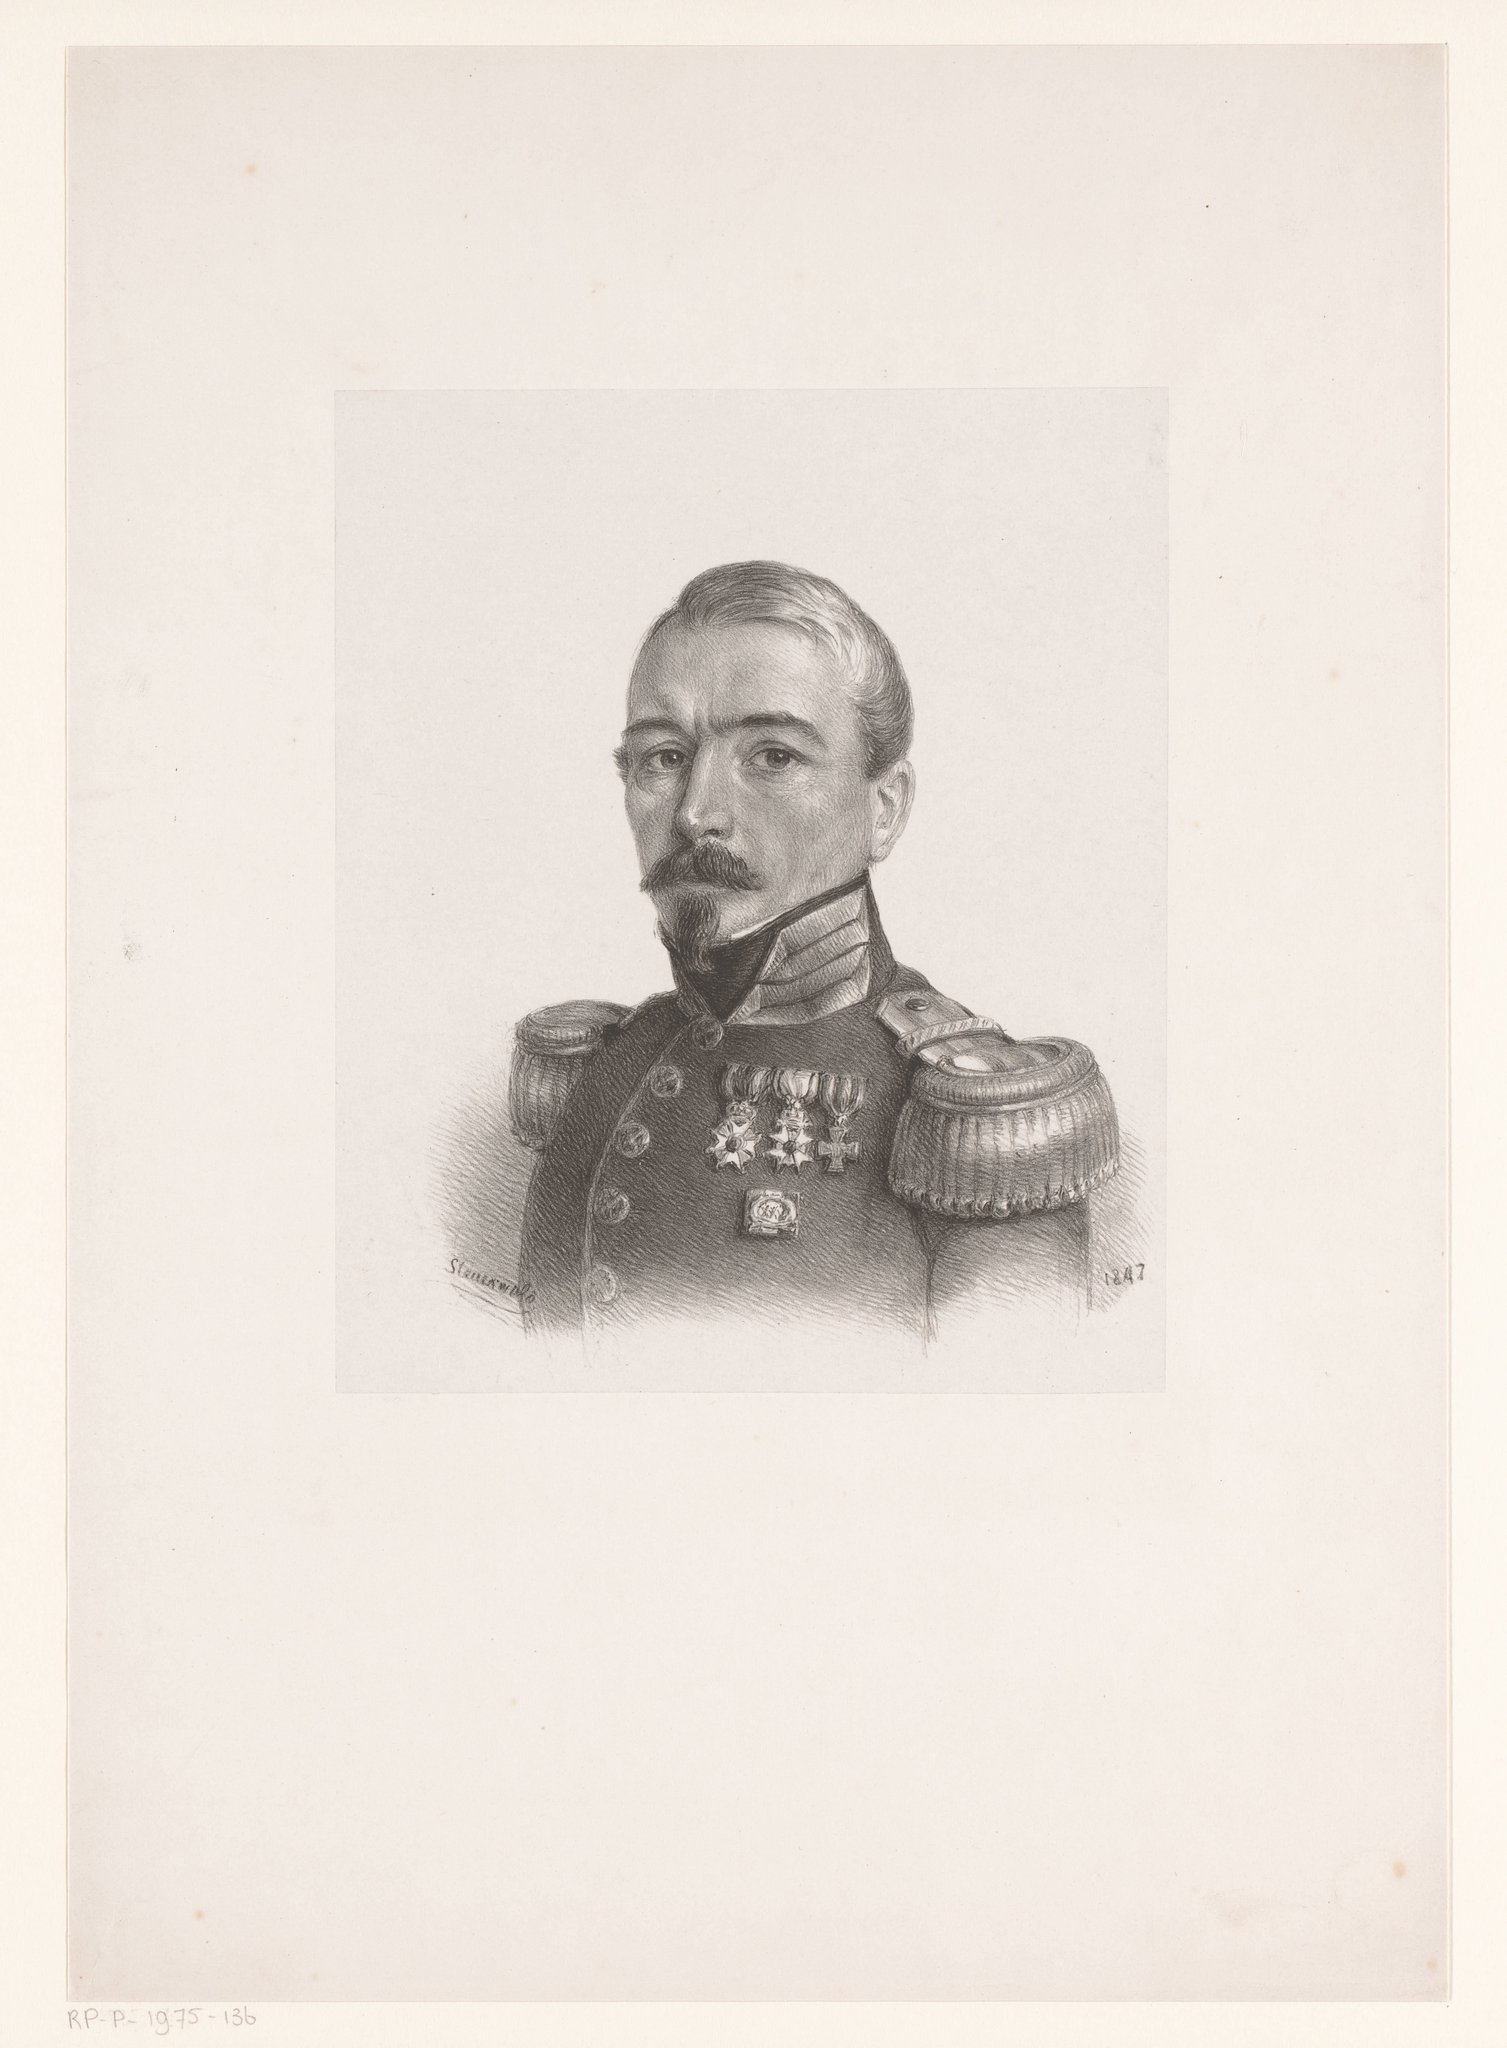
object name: print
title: Zelfportret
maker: christian heinrich gottlieb steuerwald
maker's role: draughtsman, print maker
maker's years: 1802-1874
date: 1847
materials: paper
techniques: lithograph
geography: dordrecht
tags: bergen op zoom, print maker, draughtsman, christian heinrich gottlieb steuerwald, historical persons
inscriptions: collector's mark: Lugt 2228, inscription: ‘4a / 10-9-'75’